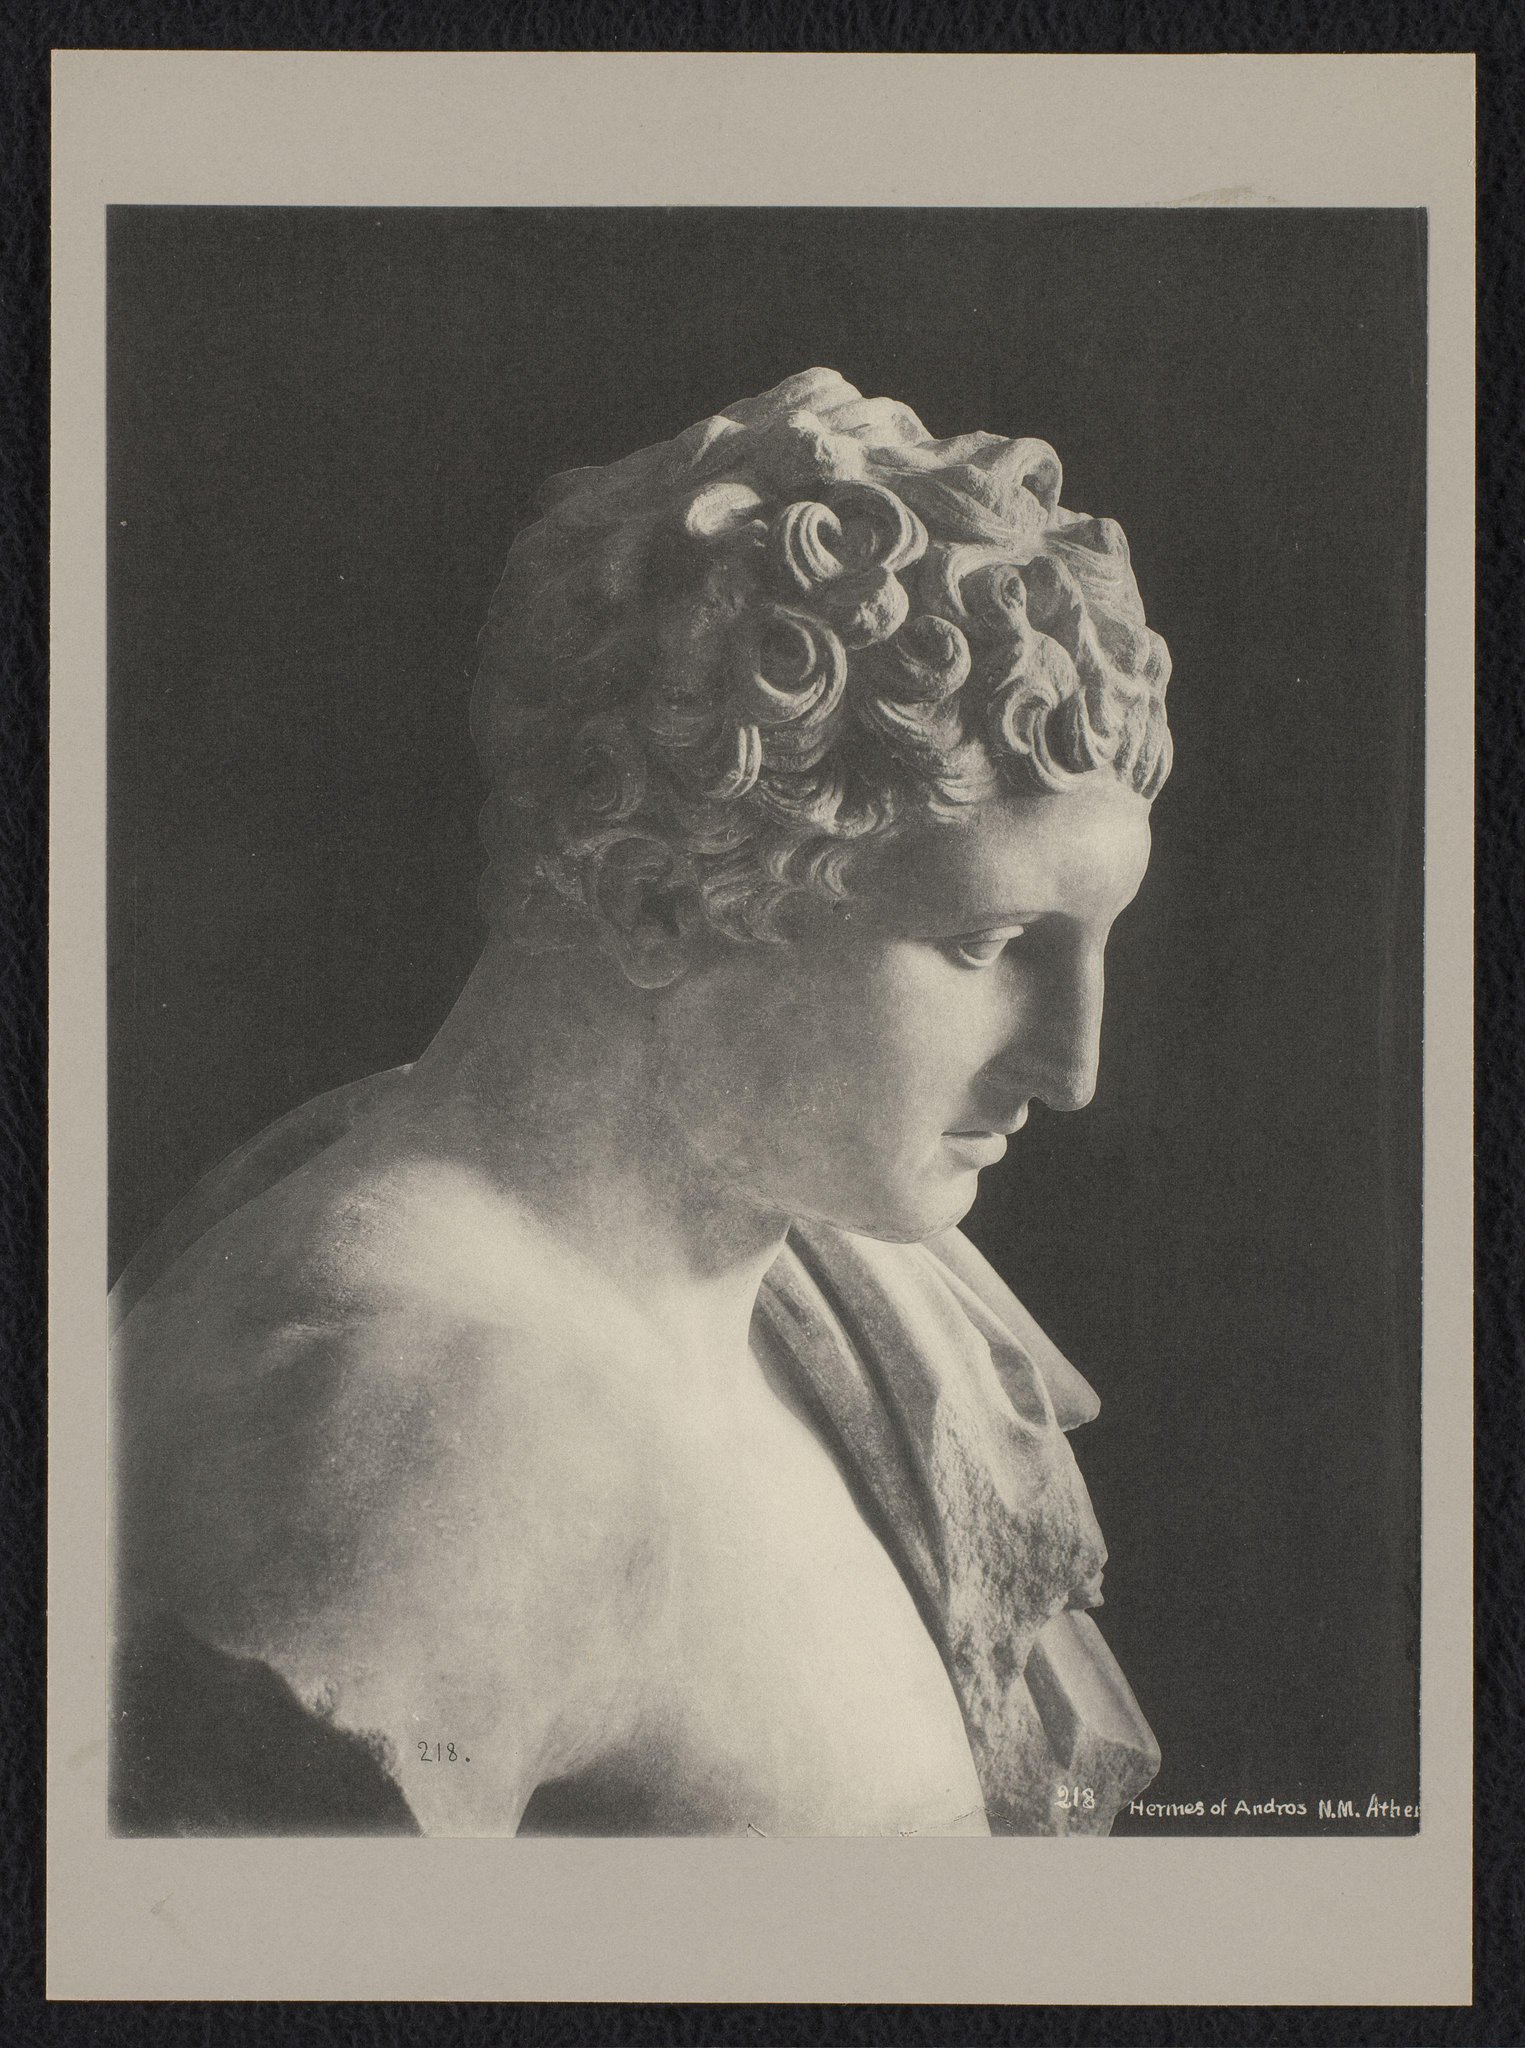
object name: photograph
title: Beeld van Hermes van Andros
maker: Anonymous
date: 1895-1915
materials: cardboard, paper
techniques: photograph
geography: athens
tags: athene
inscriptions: number: ‘35.’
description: Gezicht van Hermes van Andros. Linksonder staat het nummer 218 geschreven met pen in zwarte inkt.